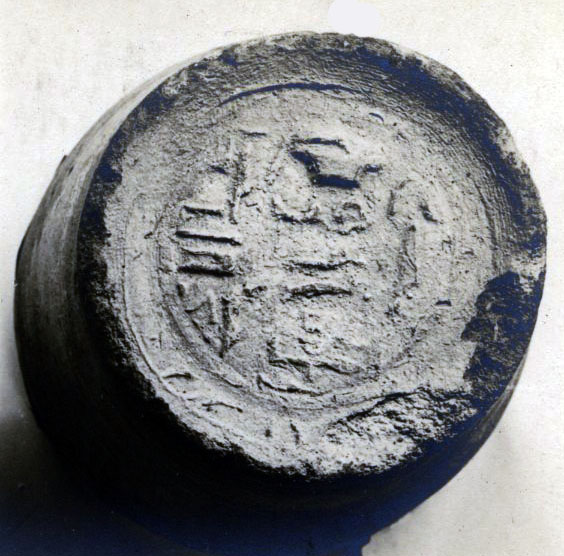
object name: cone, seshi, circular, overseer, ship, amun, anubis, hollow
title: Funerary Cone of the Overseer of the Ships of Amun Seshi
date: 1550-1295 BCE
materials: pottery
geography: egypt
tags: hieroglyphs